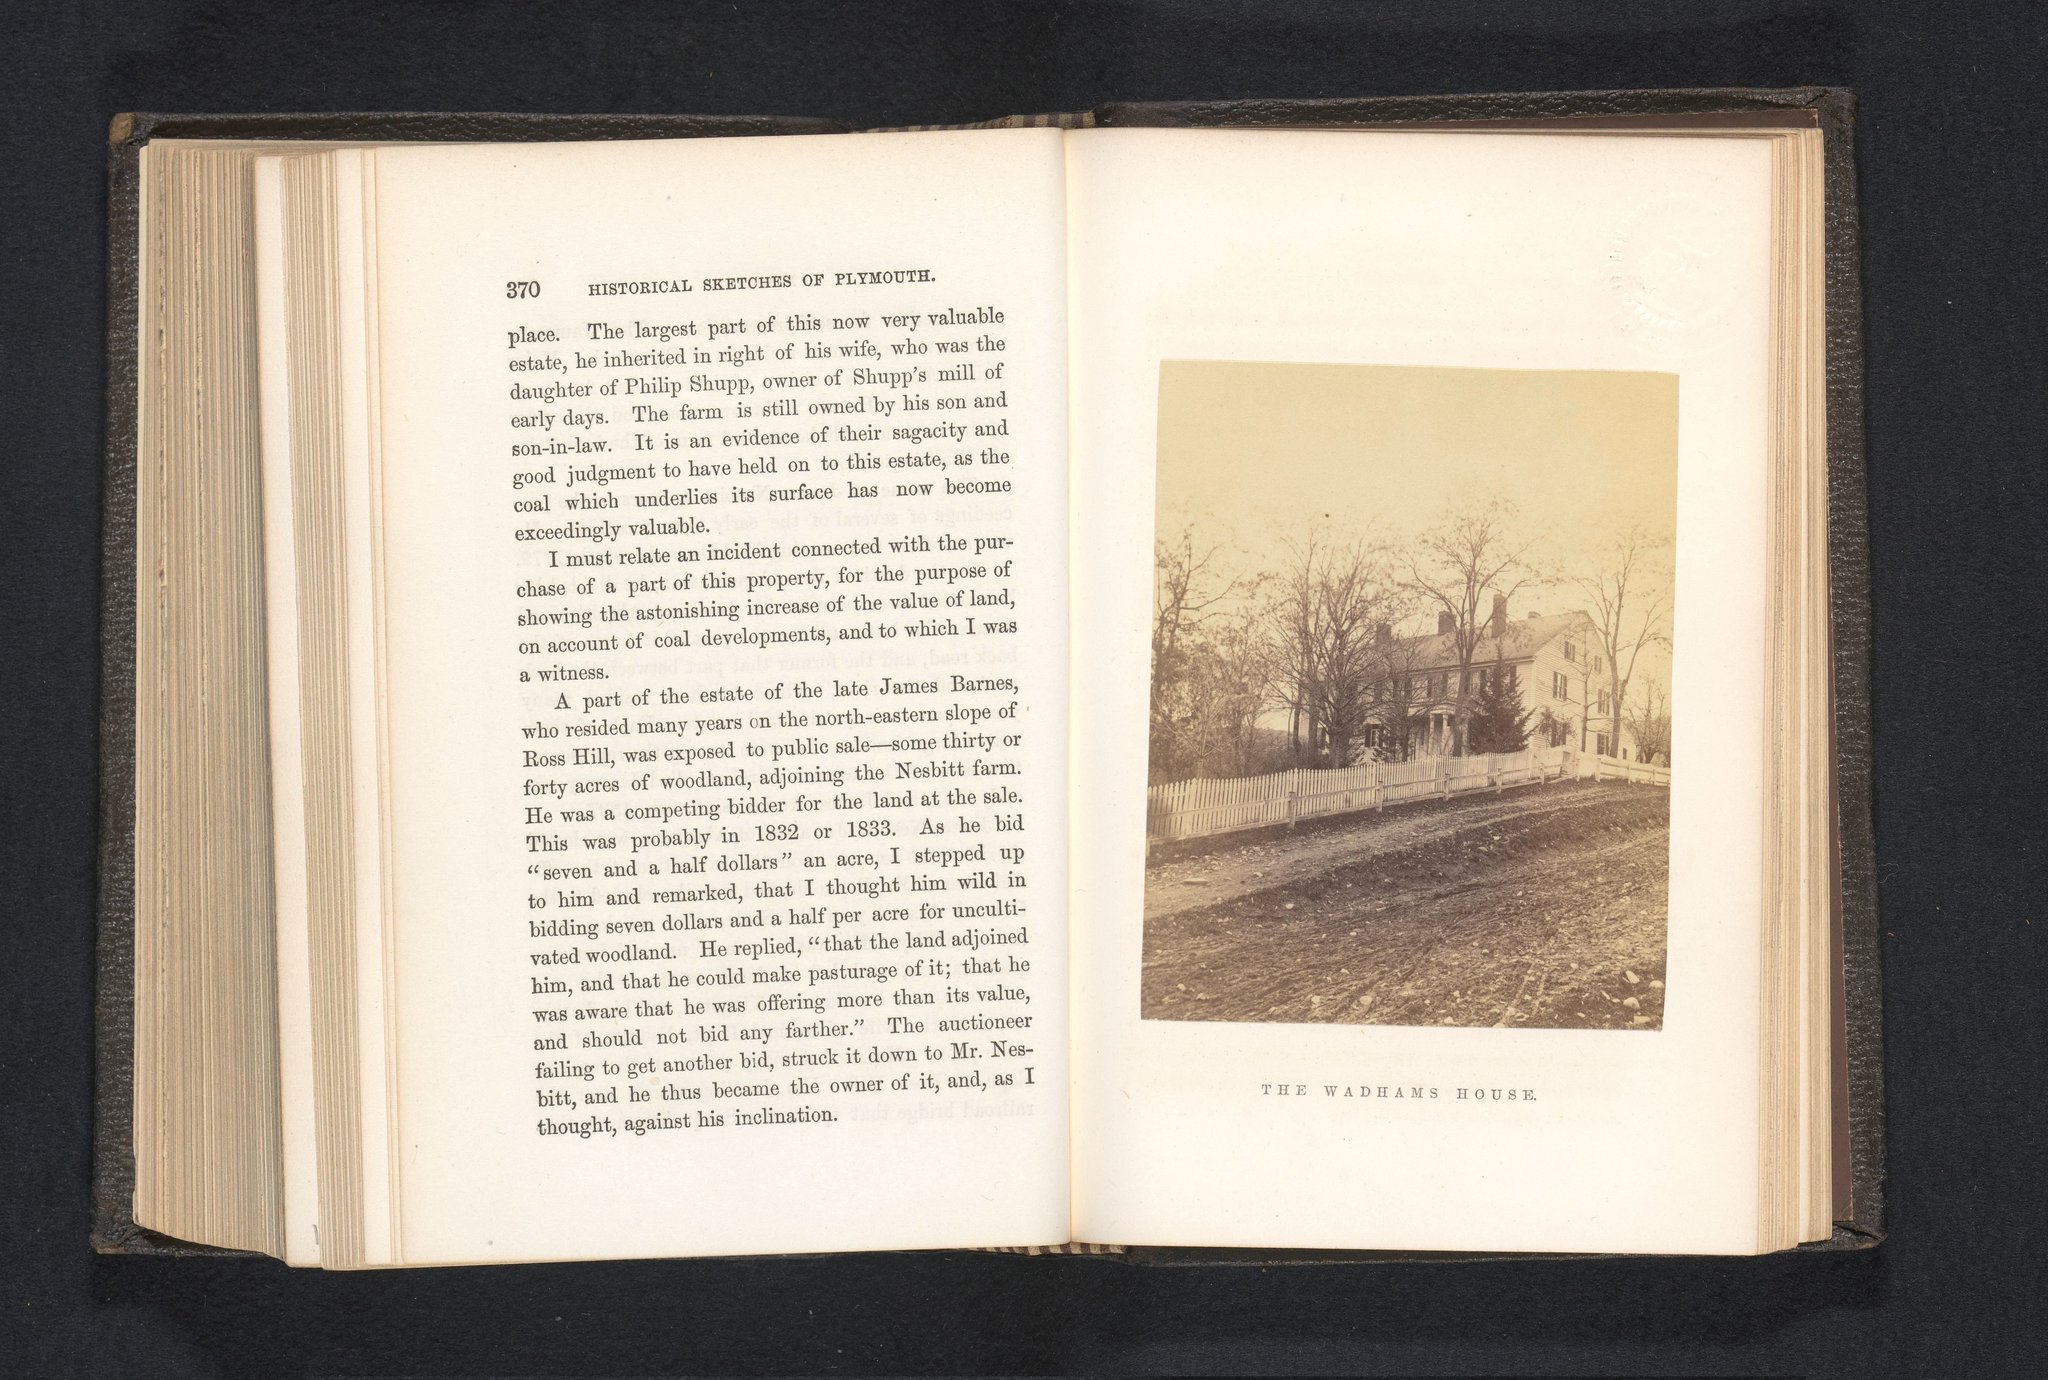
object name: page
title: Gezicht op het huis van de familie Wadhams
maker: william h. schurch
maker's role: fotograaf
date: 1868-1873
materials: photographic support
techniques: albumen print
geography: luzerne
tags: façade (of house or building)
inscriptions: collector's mark: ‘Essex Institute 1848’